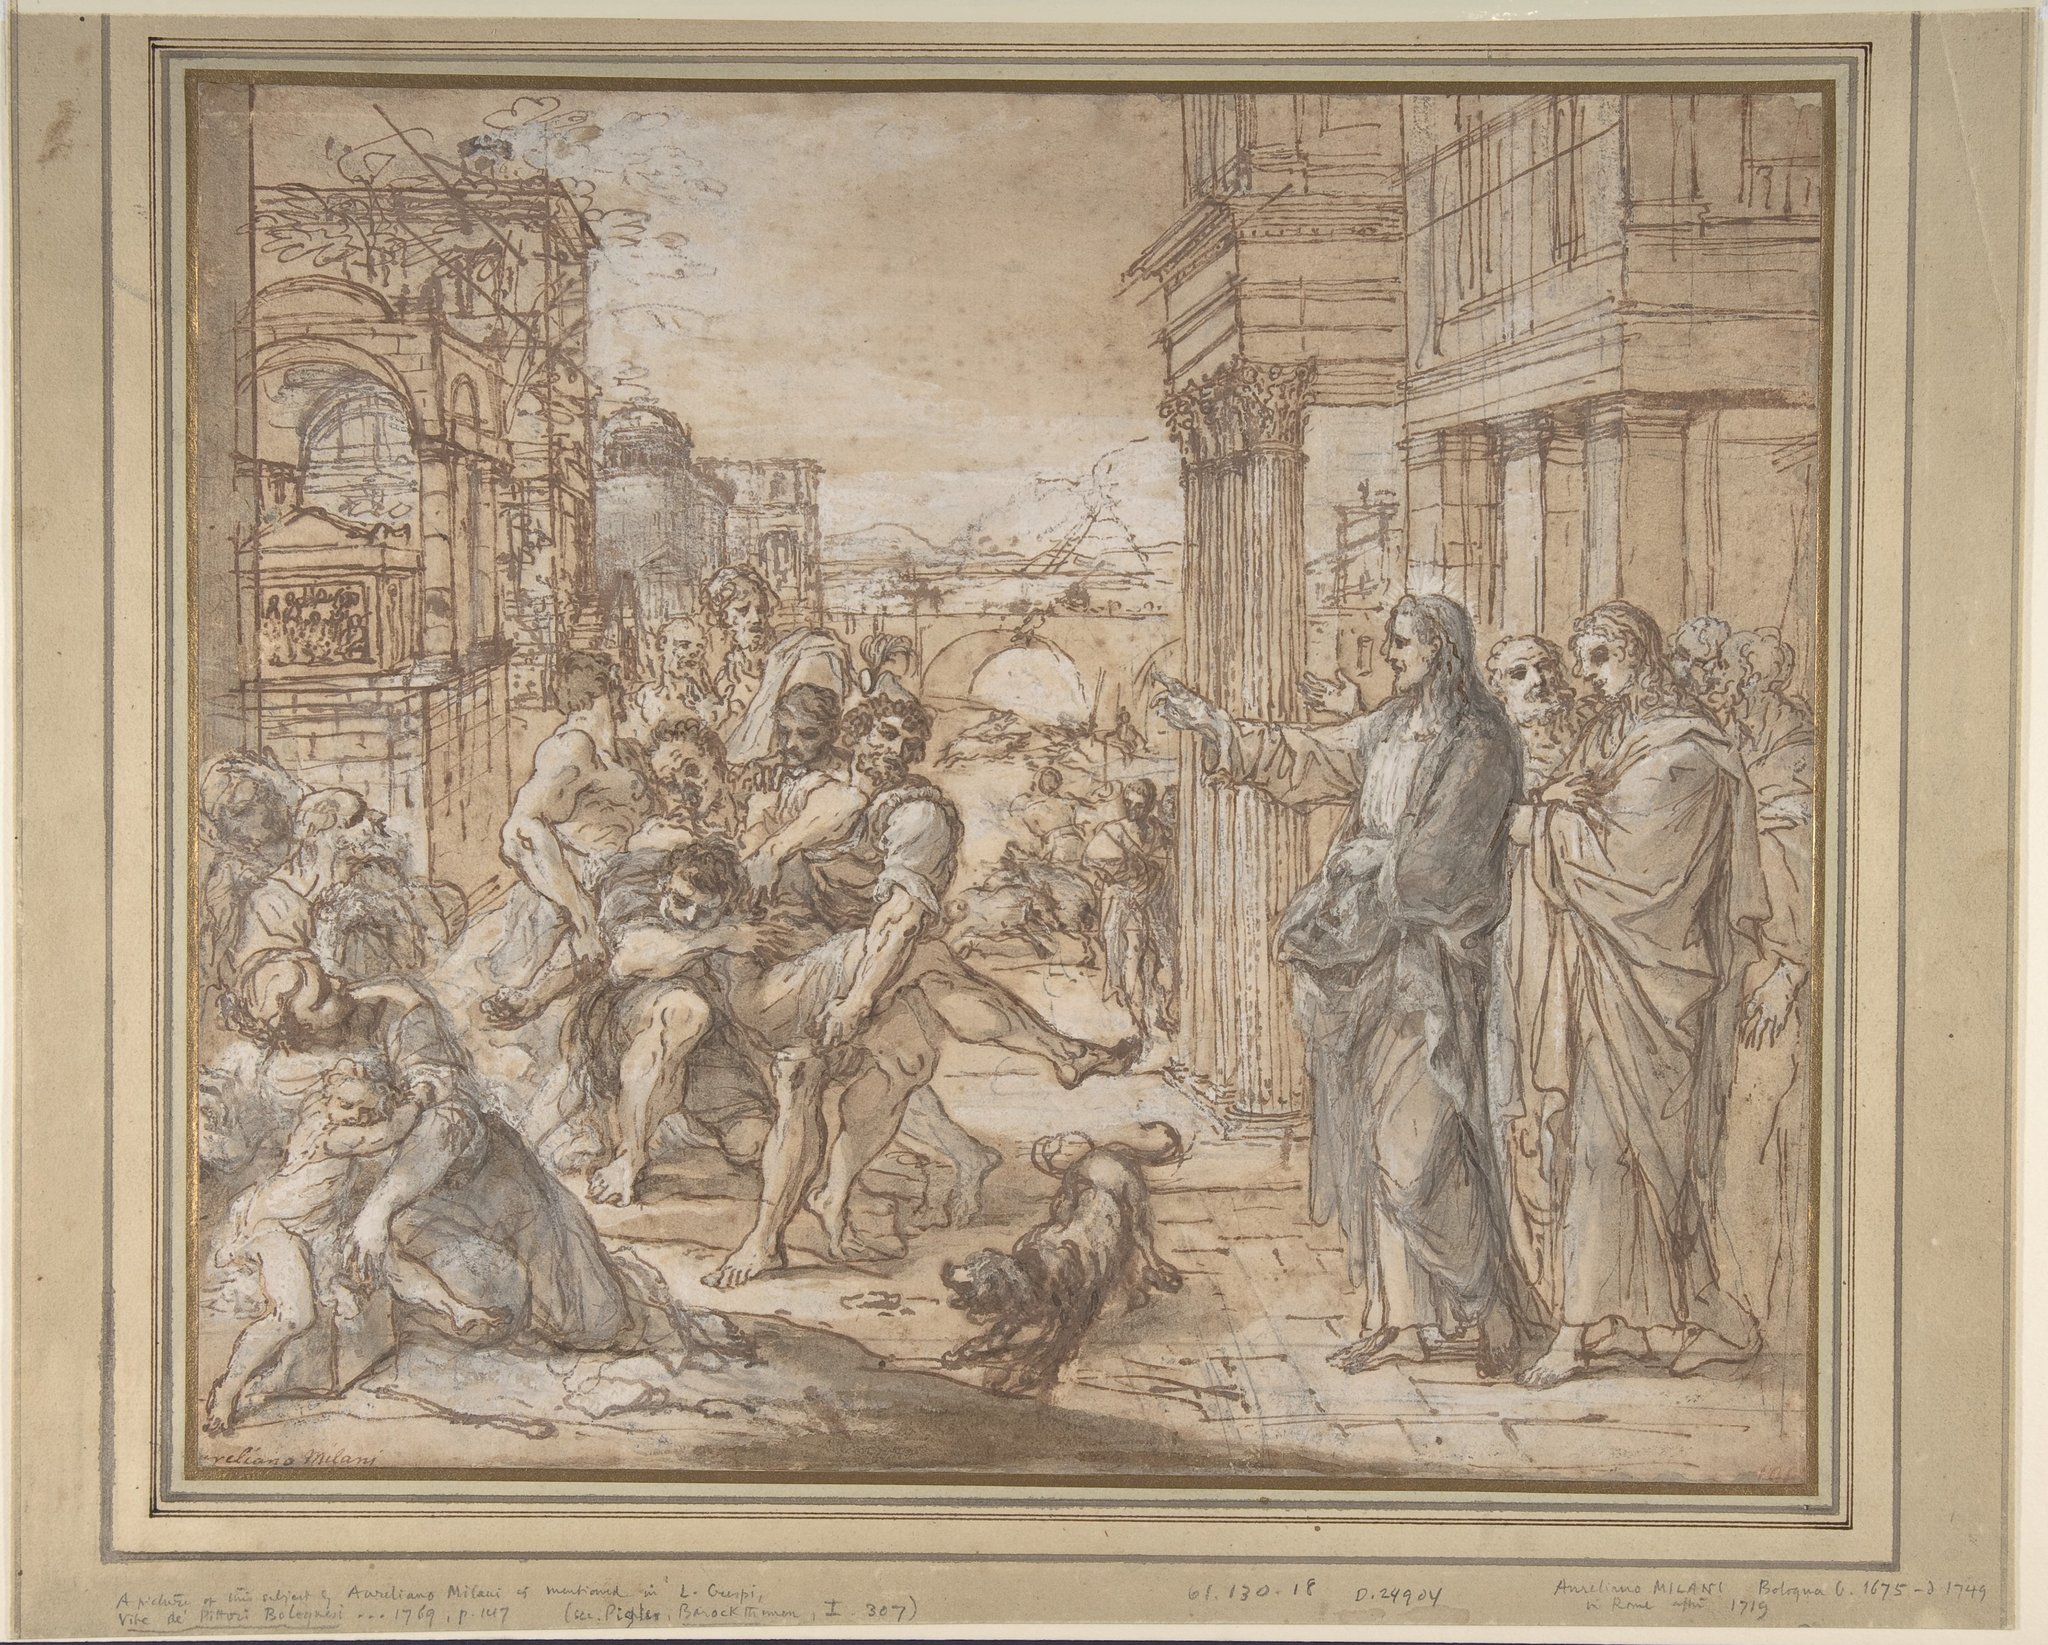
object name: drawing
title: Christ Healing a Possessed Man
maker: aureliano milani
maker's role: artist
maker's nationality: italian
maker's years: 1675-1749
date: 1675-1749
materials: chalk, ink, paper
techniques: brush, highlighting, pen, wash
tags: illness,men,dogs,christ